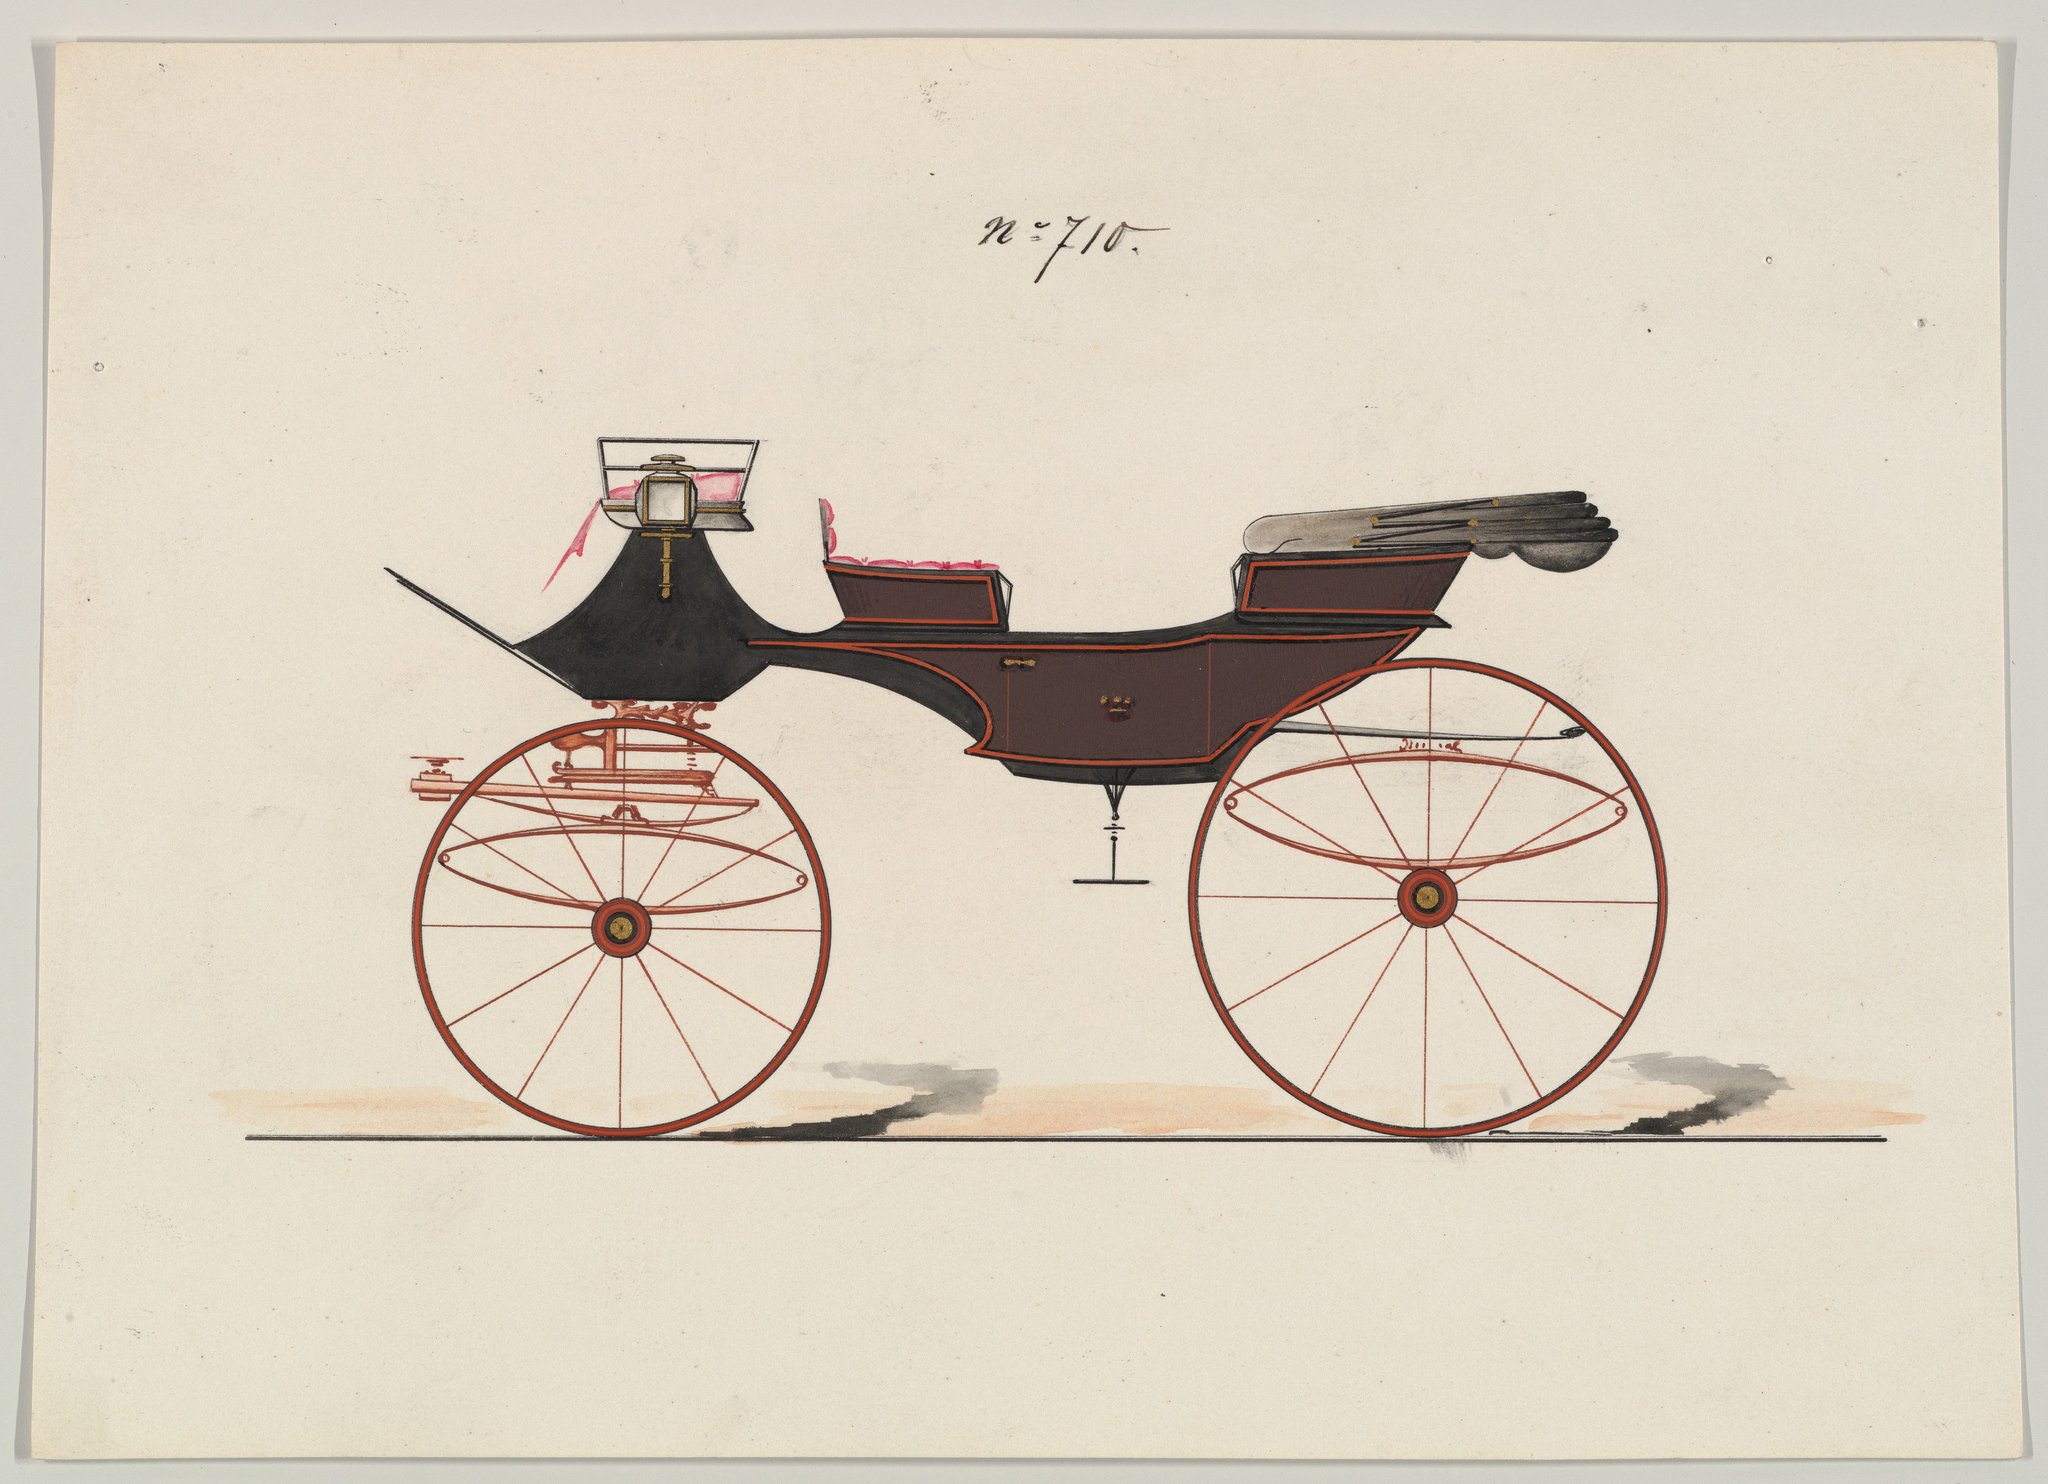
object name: drawing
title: Design for Vis-à-vis, no. 710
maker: brewster & co.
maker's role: manufacturer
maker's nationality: american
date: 1850-1870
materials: gouache, ink, watercolor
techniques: pen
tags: carriages